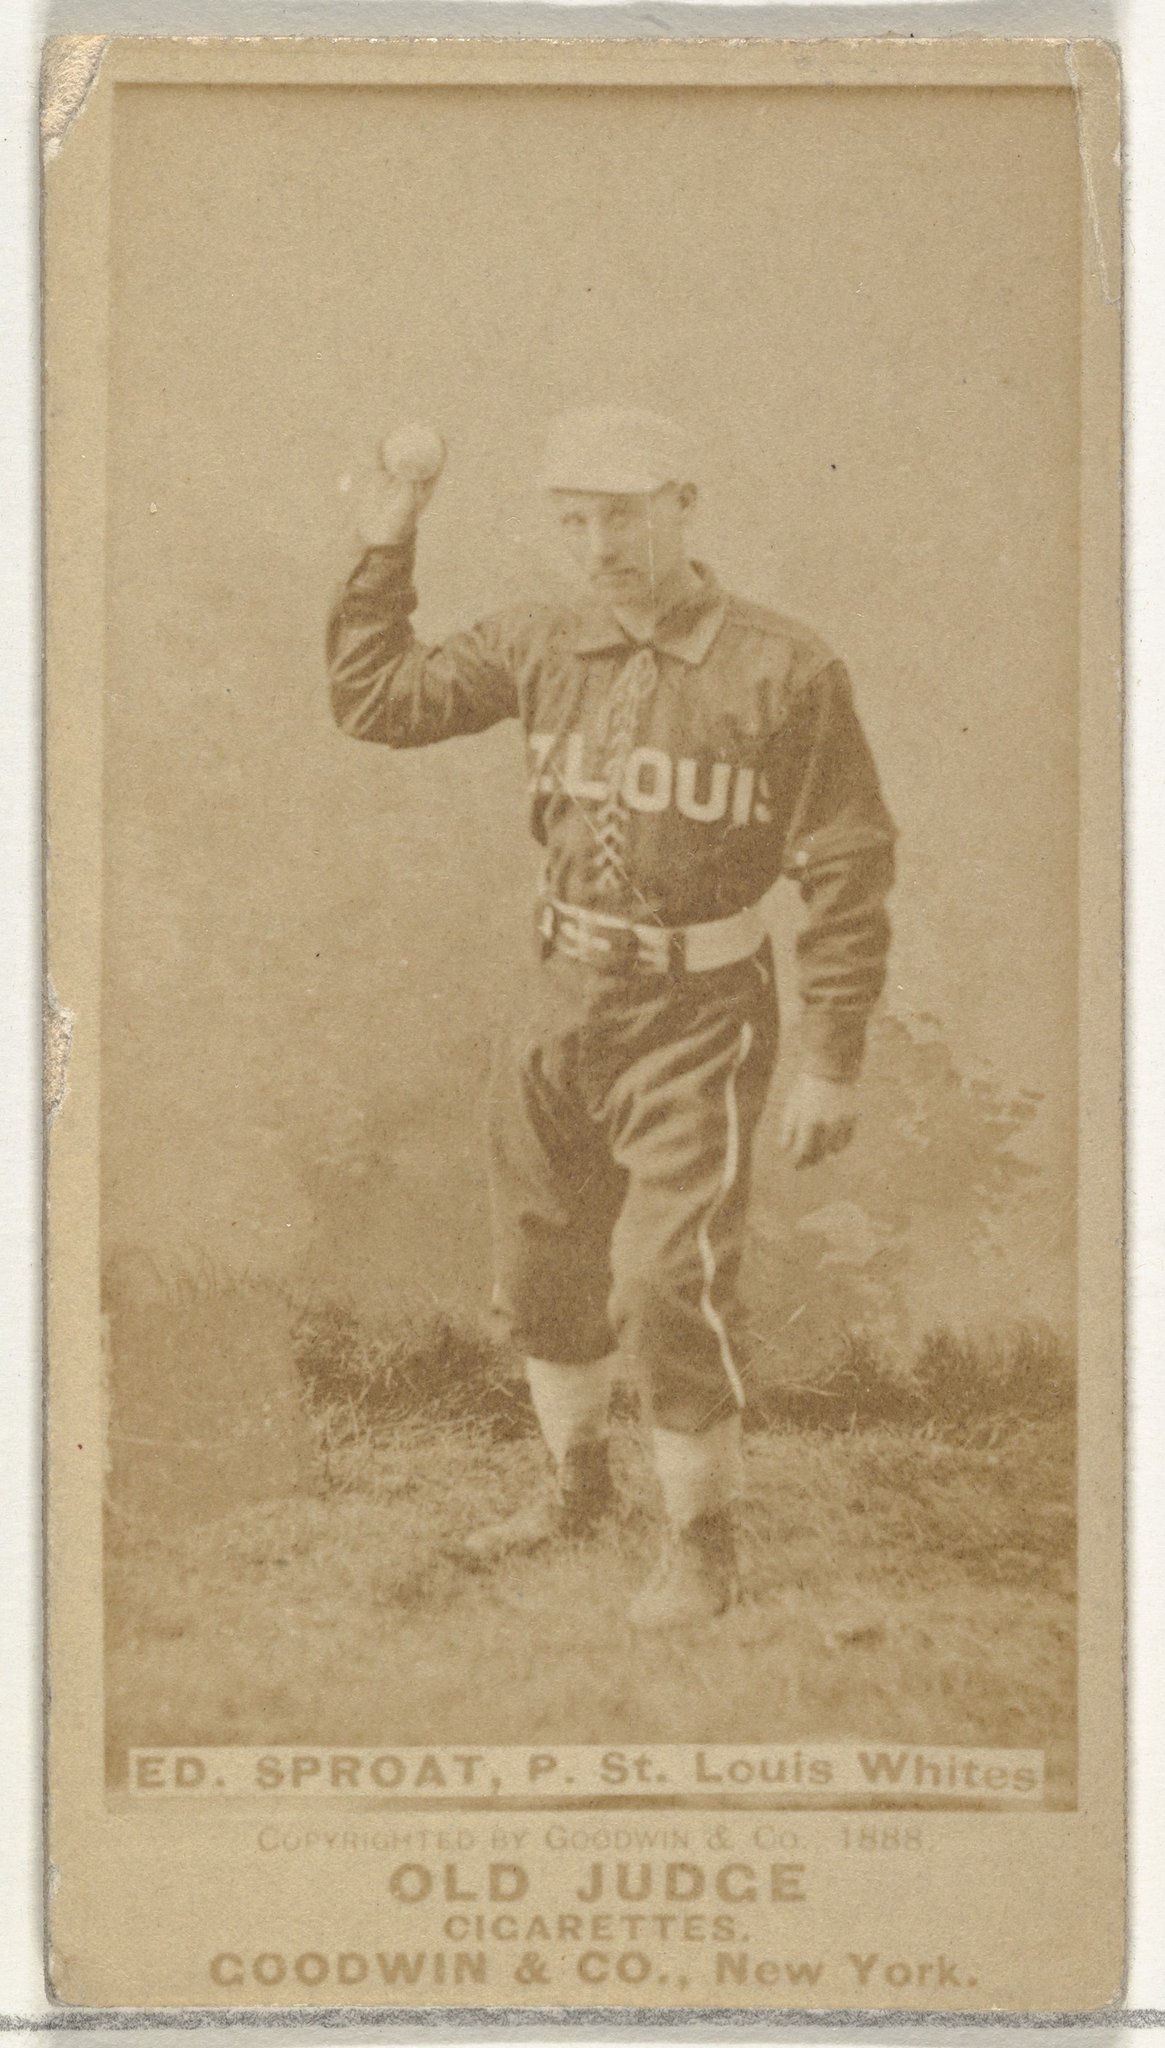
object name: baseball card, photograph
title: Sproat, Pitcher, St. Louis Whites, from the Old Judge series (N172) for Old Judge Cigarettes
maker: goodwin & company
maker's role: publisher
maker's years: 1850-1950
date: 1888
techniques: albumen silver print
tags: men,portraits,baseball,athletes